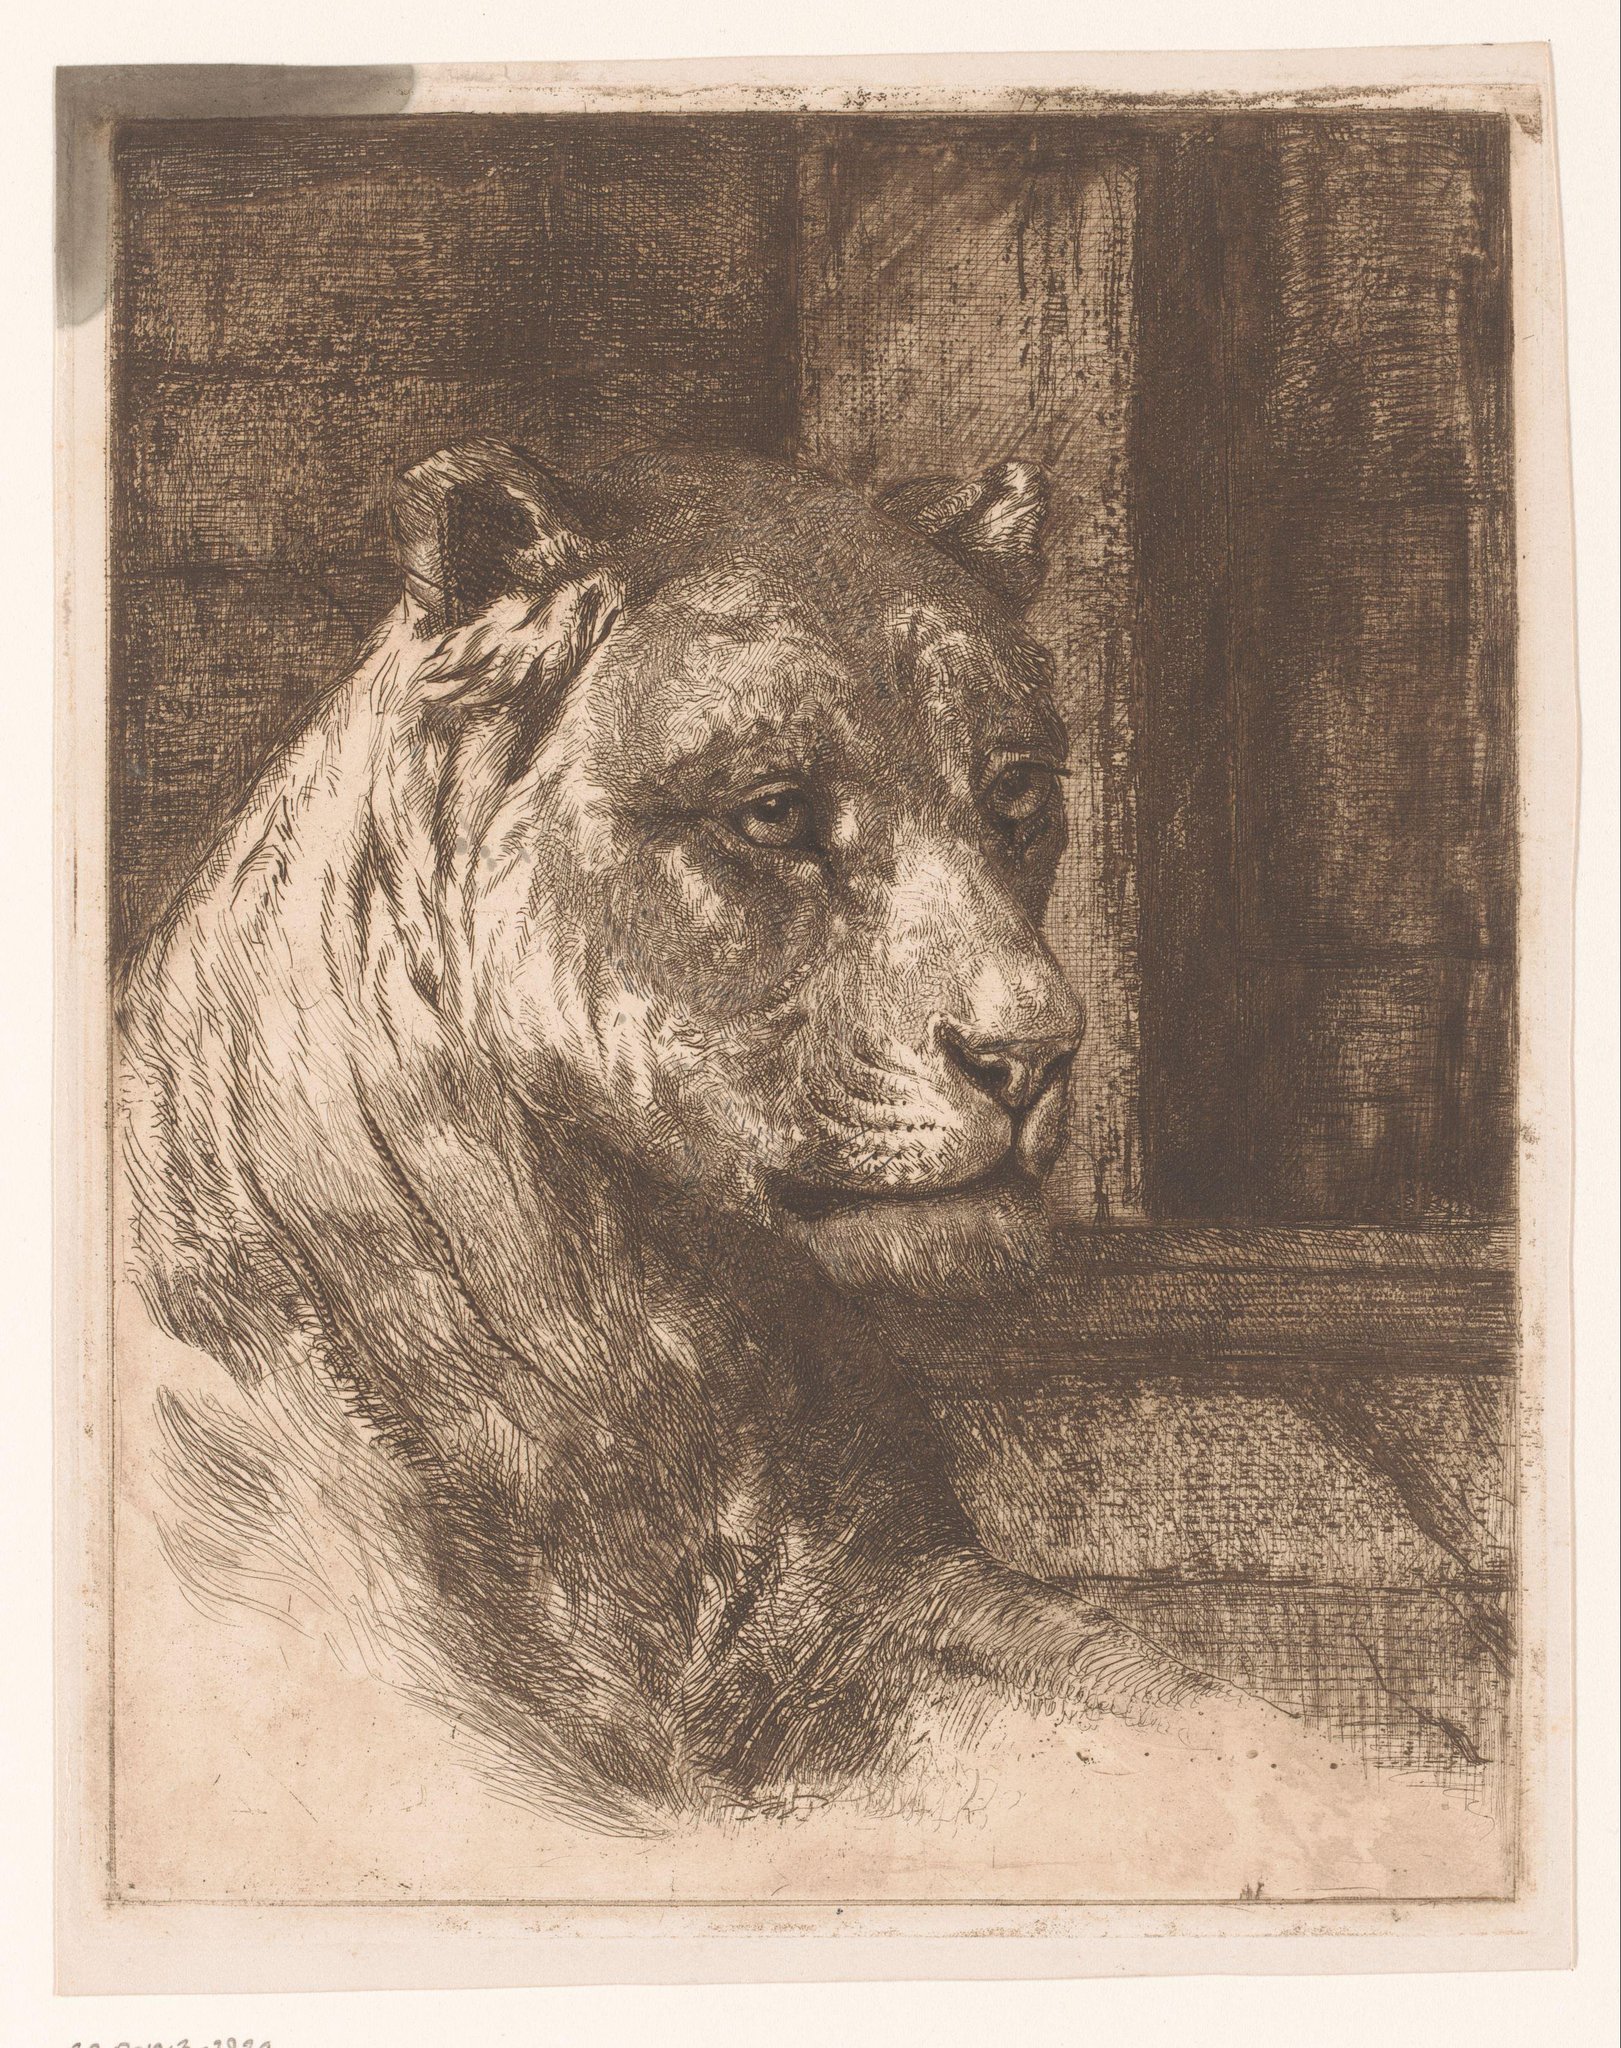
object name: print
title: Kop van een liggende leeuwin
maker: joseph schippers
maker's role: print maker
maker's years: 1868-1950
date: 1878-1913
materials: paper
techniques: etching, intaglio, retroussage, roulette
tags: beasts of prey, predatory animals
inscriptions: collector's mark: Lugt 2228